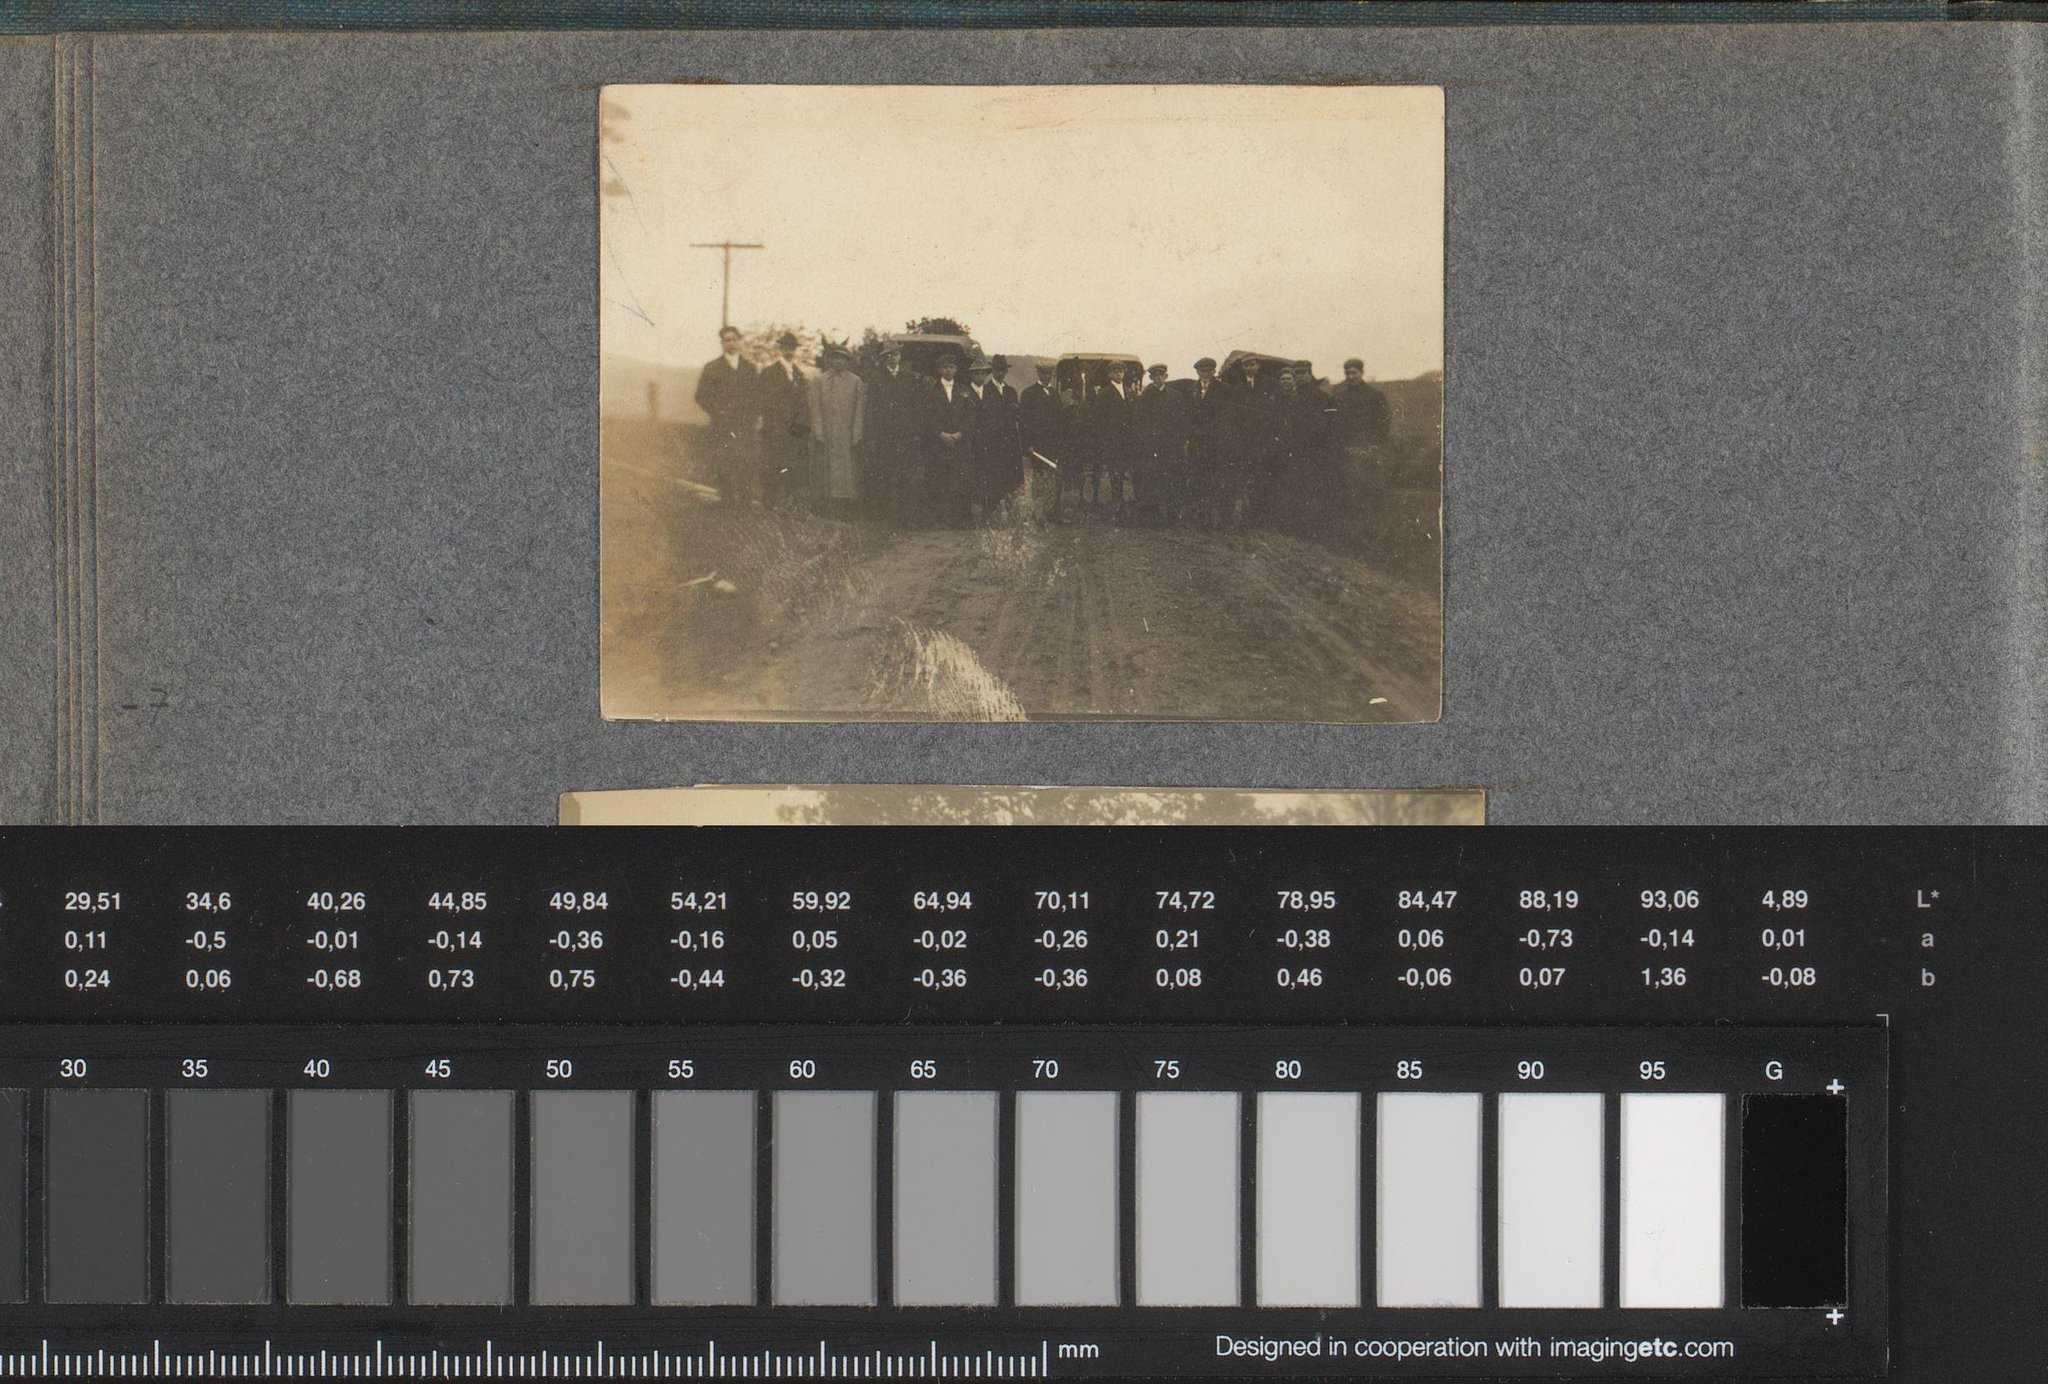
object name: album leaf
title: Groep jongens op een landweg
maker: Anonymous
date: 1905-1910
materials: paper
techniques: gelatin silver print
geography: united states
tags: road, path, anonymous historical persons portrayed in a group, in a group-portrait, united states of america